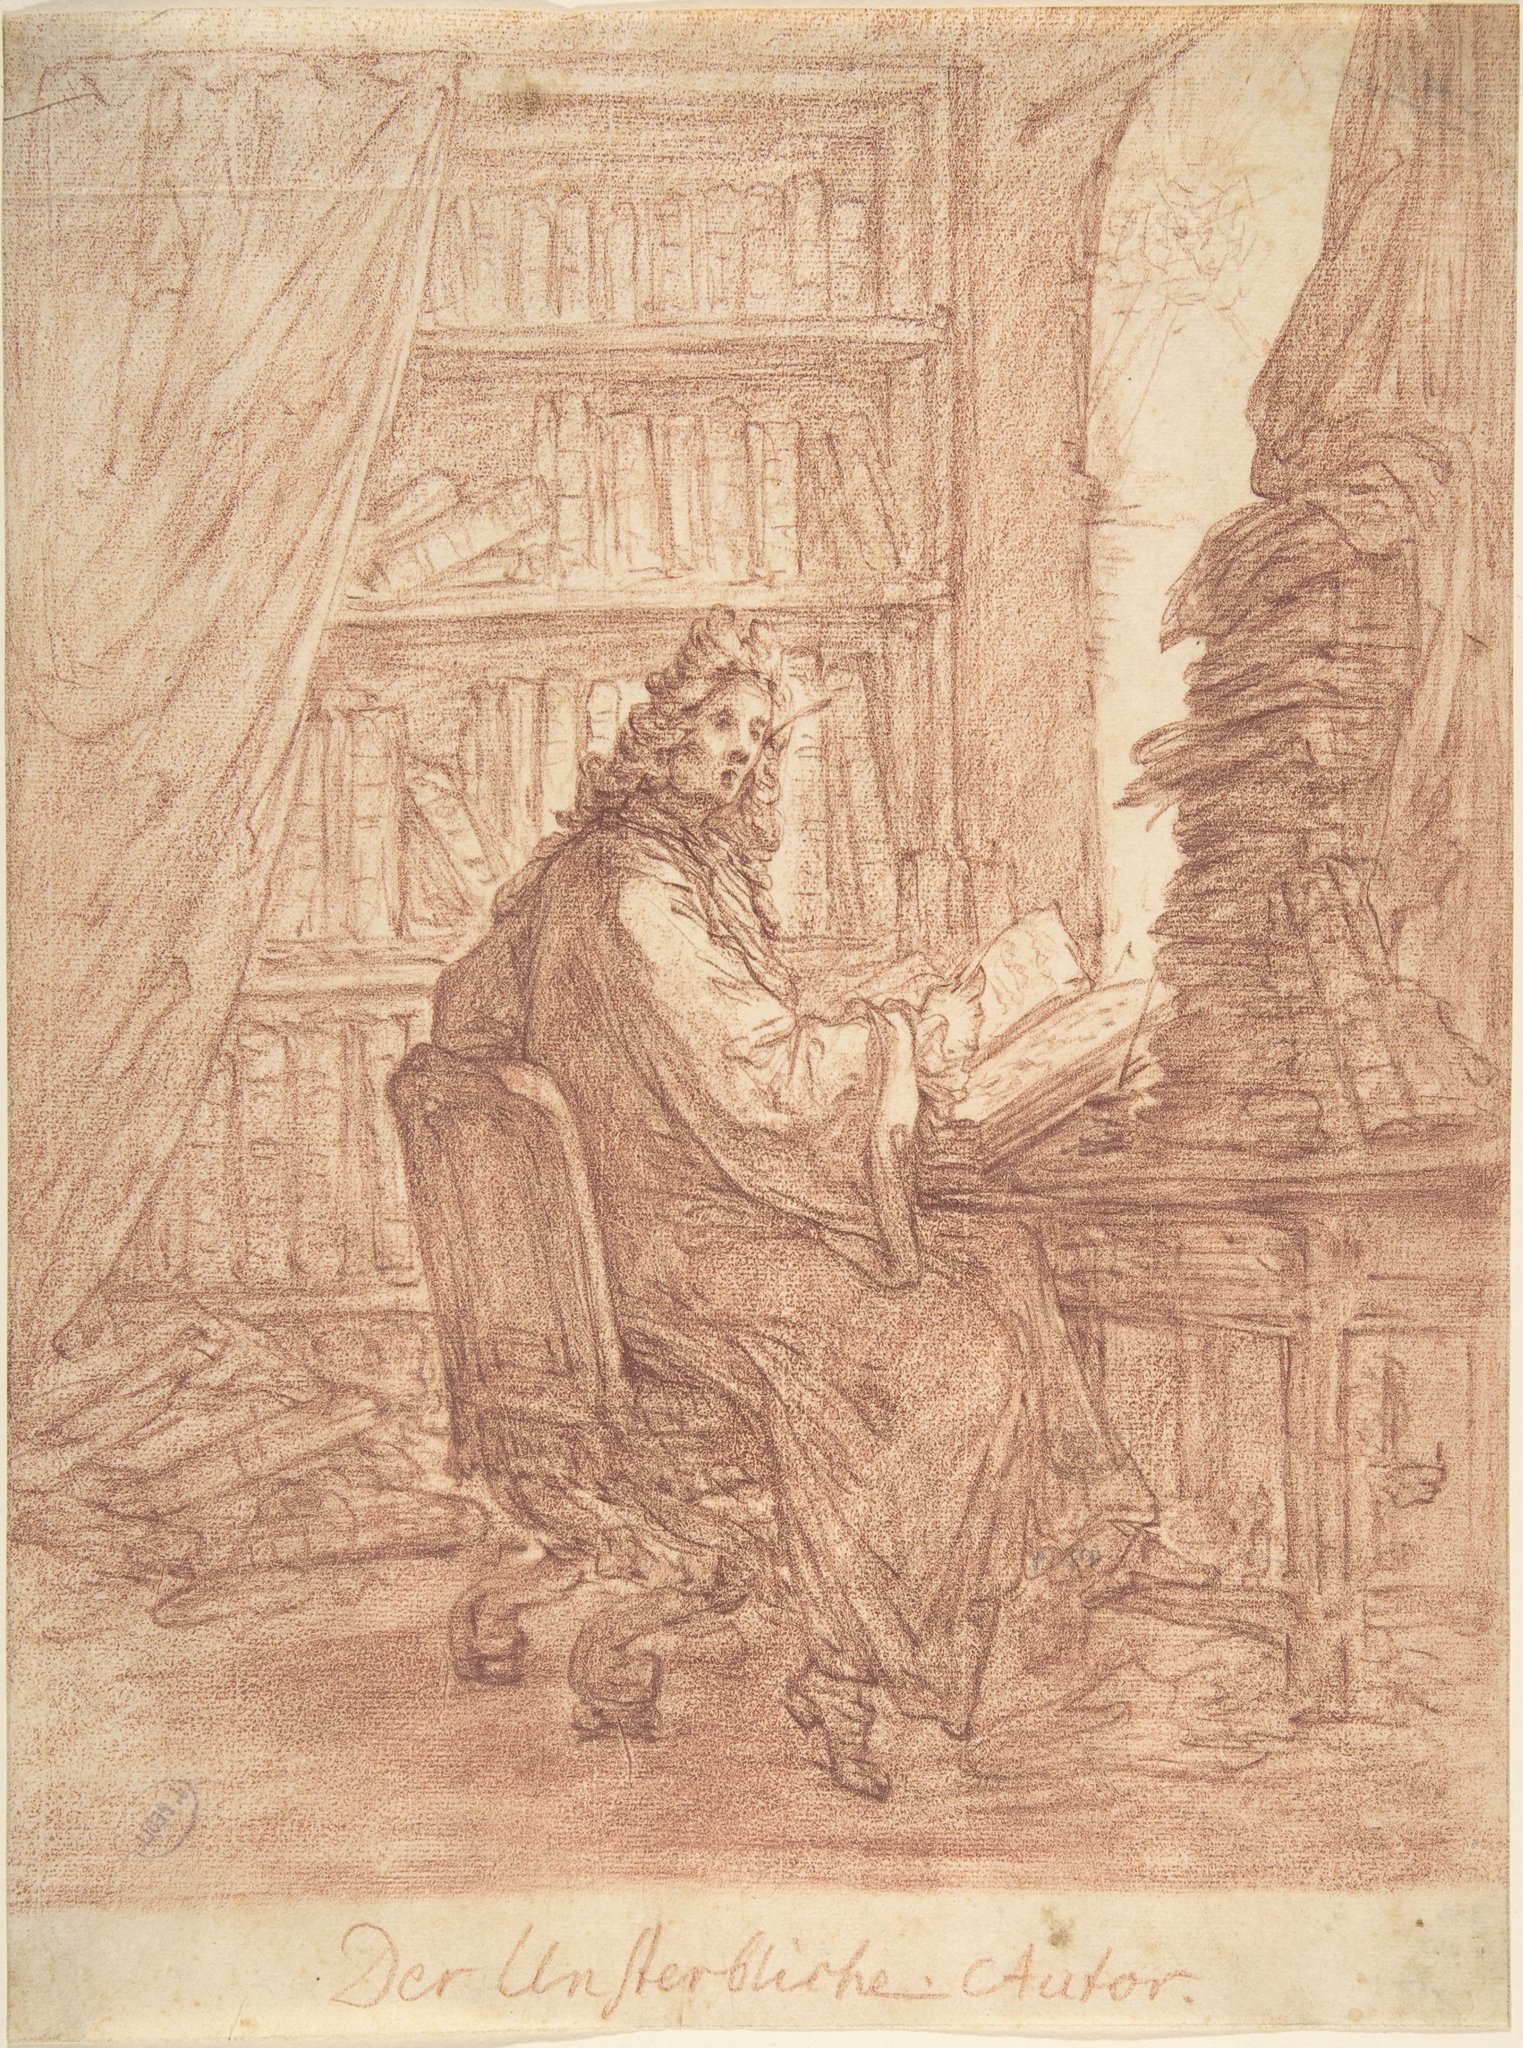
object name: drawing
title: The Immortal Author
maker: bernhard rode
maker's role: artist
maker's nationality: german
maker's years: 1725-1797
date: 1740-1797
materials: chalk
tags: books,men,writing